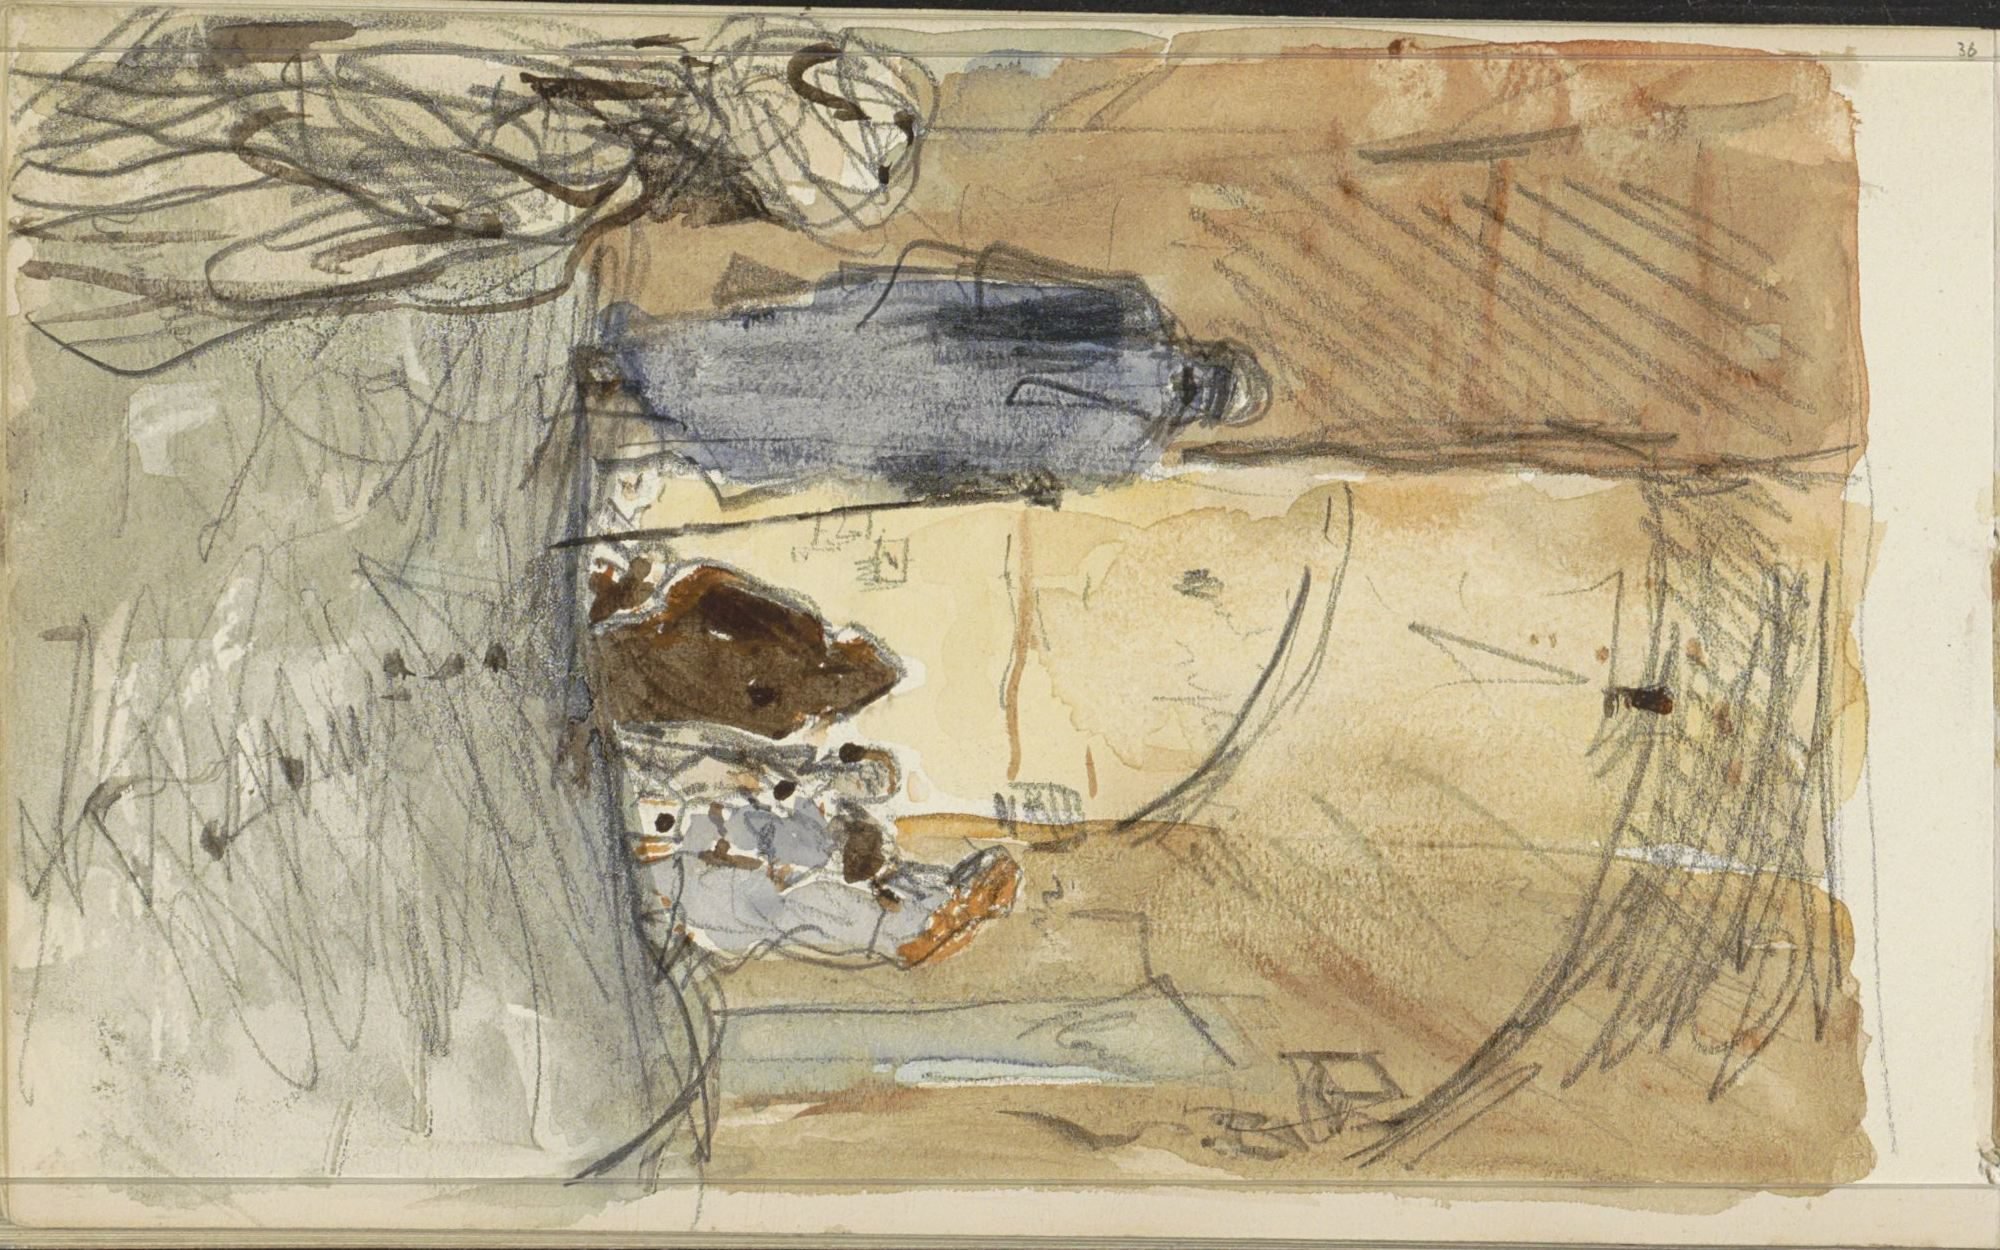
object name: sketchbook leaf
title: Straat met figuren bij een trap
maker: marius bauer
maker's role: draughtsman, print maker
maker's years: 1867-1932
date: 1922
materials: paper, pencil, watercolor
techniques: brush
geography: biskra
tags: africans, street (+ city(-scape) with figures, staffage)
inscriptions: kleurnotitie, handgeschreven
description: Pagina 36 uit een schetsboek met 31 bladen.